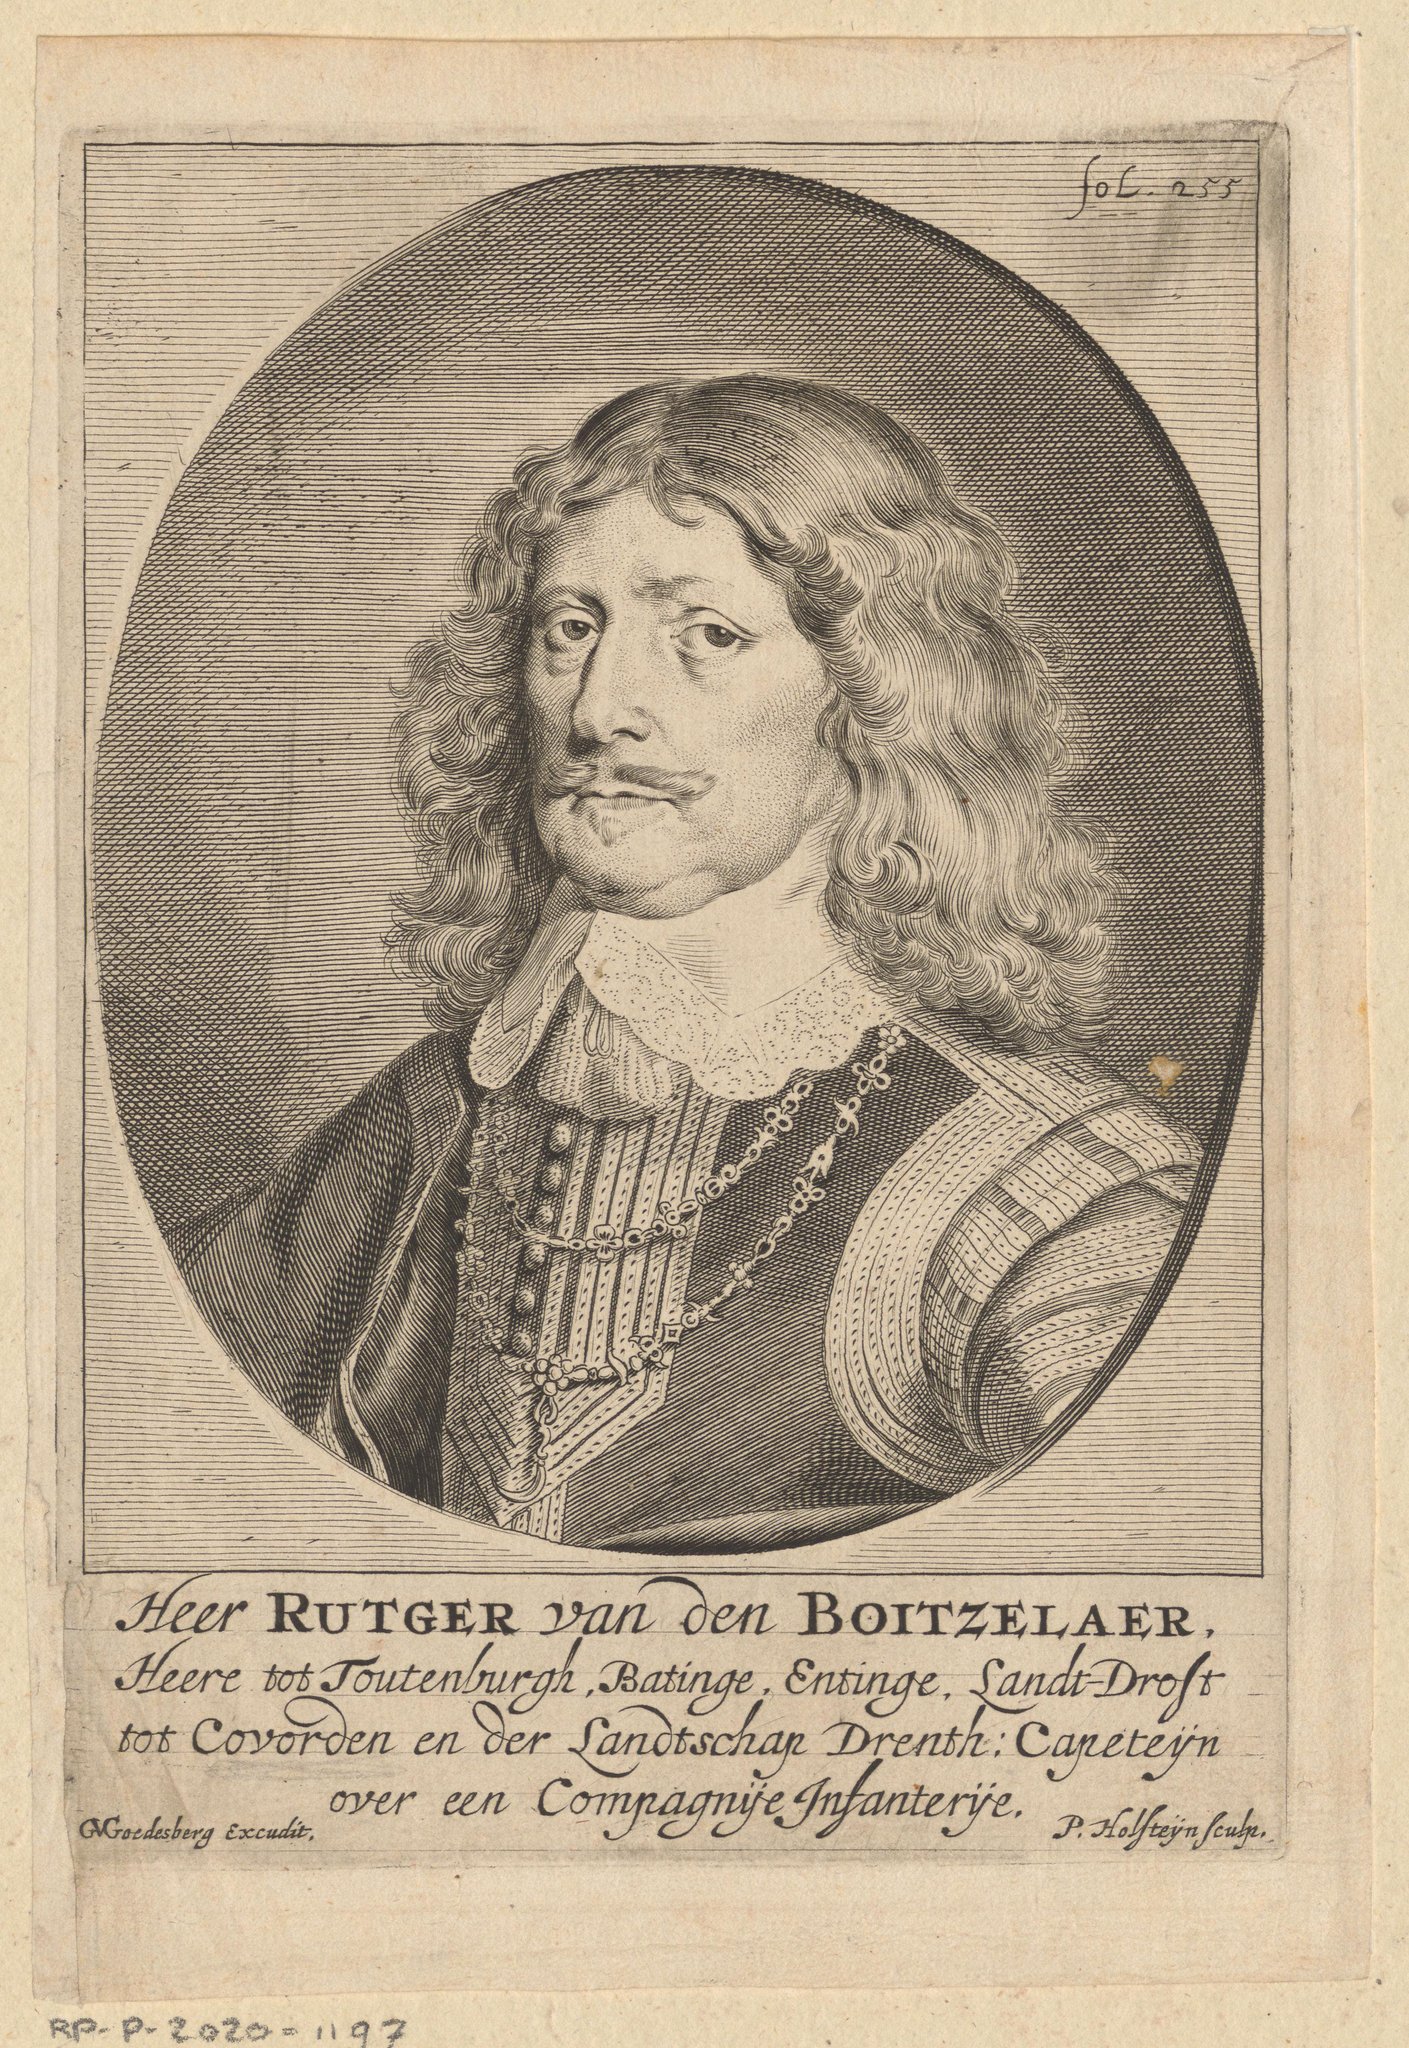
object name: book illustration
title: Portret van Rutger Wessel van den Boetzelaer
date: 1660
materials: paper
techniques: engraving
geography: amsterdam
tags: historical persons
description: Prent uit: Picardt, Johan. Korte beschryvinge van eenige vergetene en verborgene antiquiteten der provintien en landen gelegen tusschen de Noord-zee, de Yssel, Emse en Lippe. Amsterdam: Gerrit van Goedesberg, 1660.